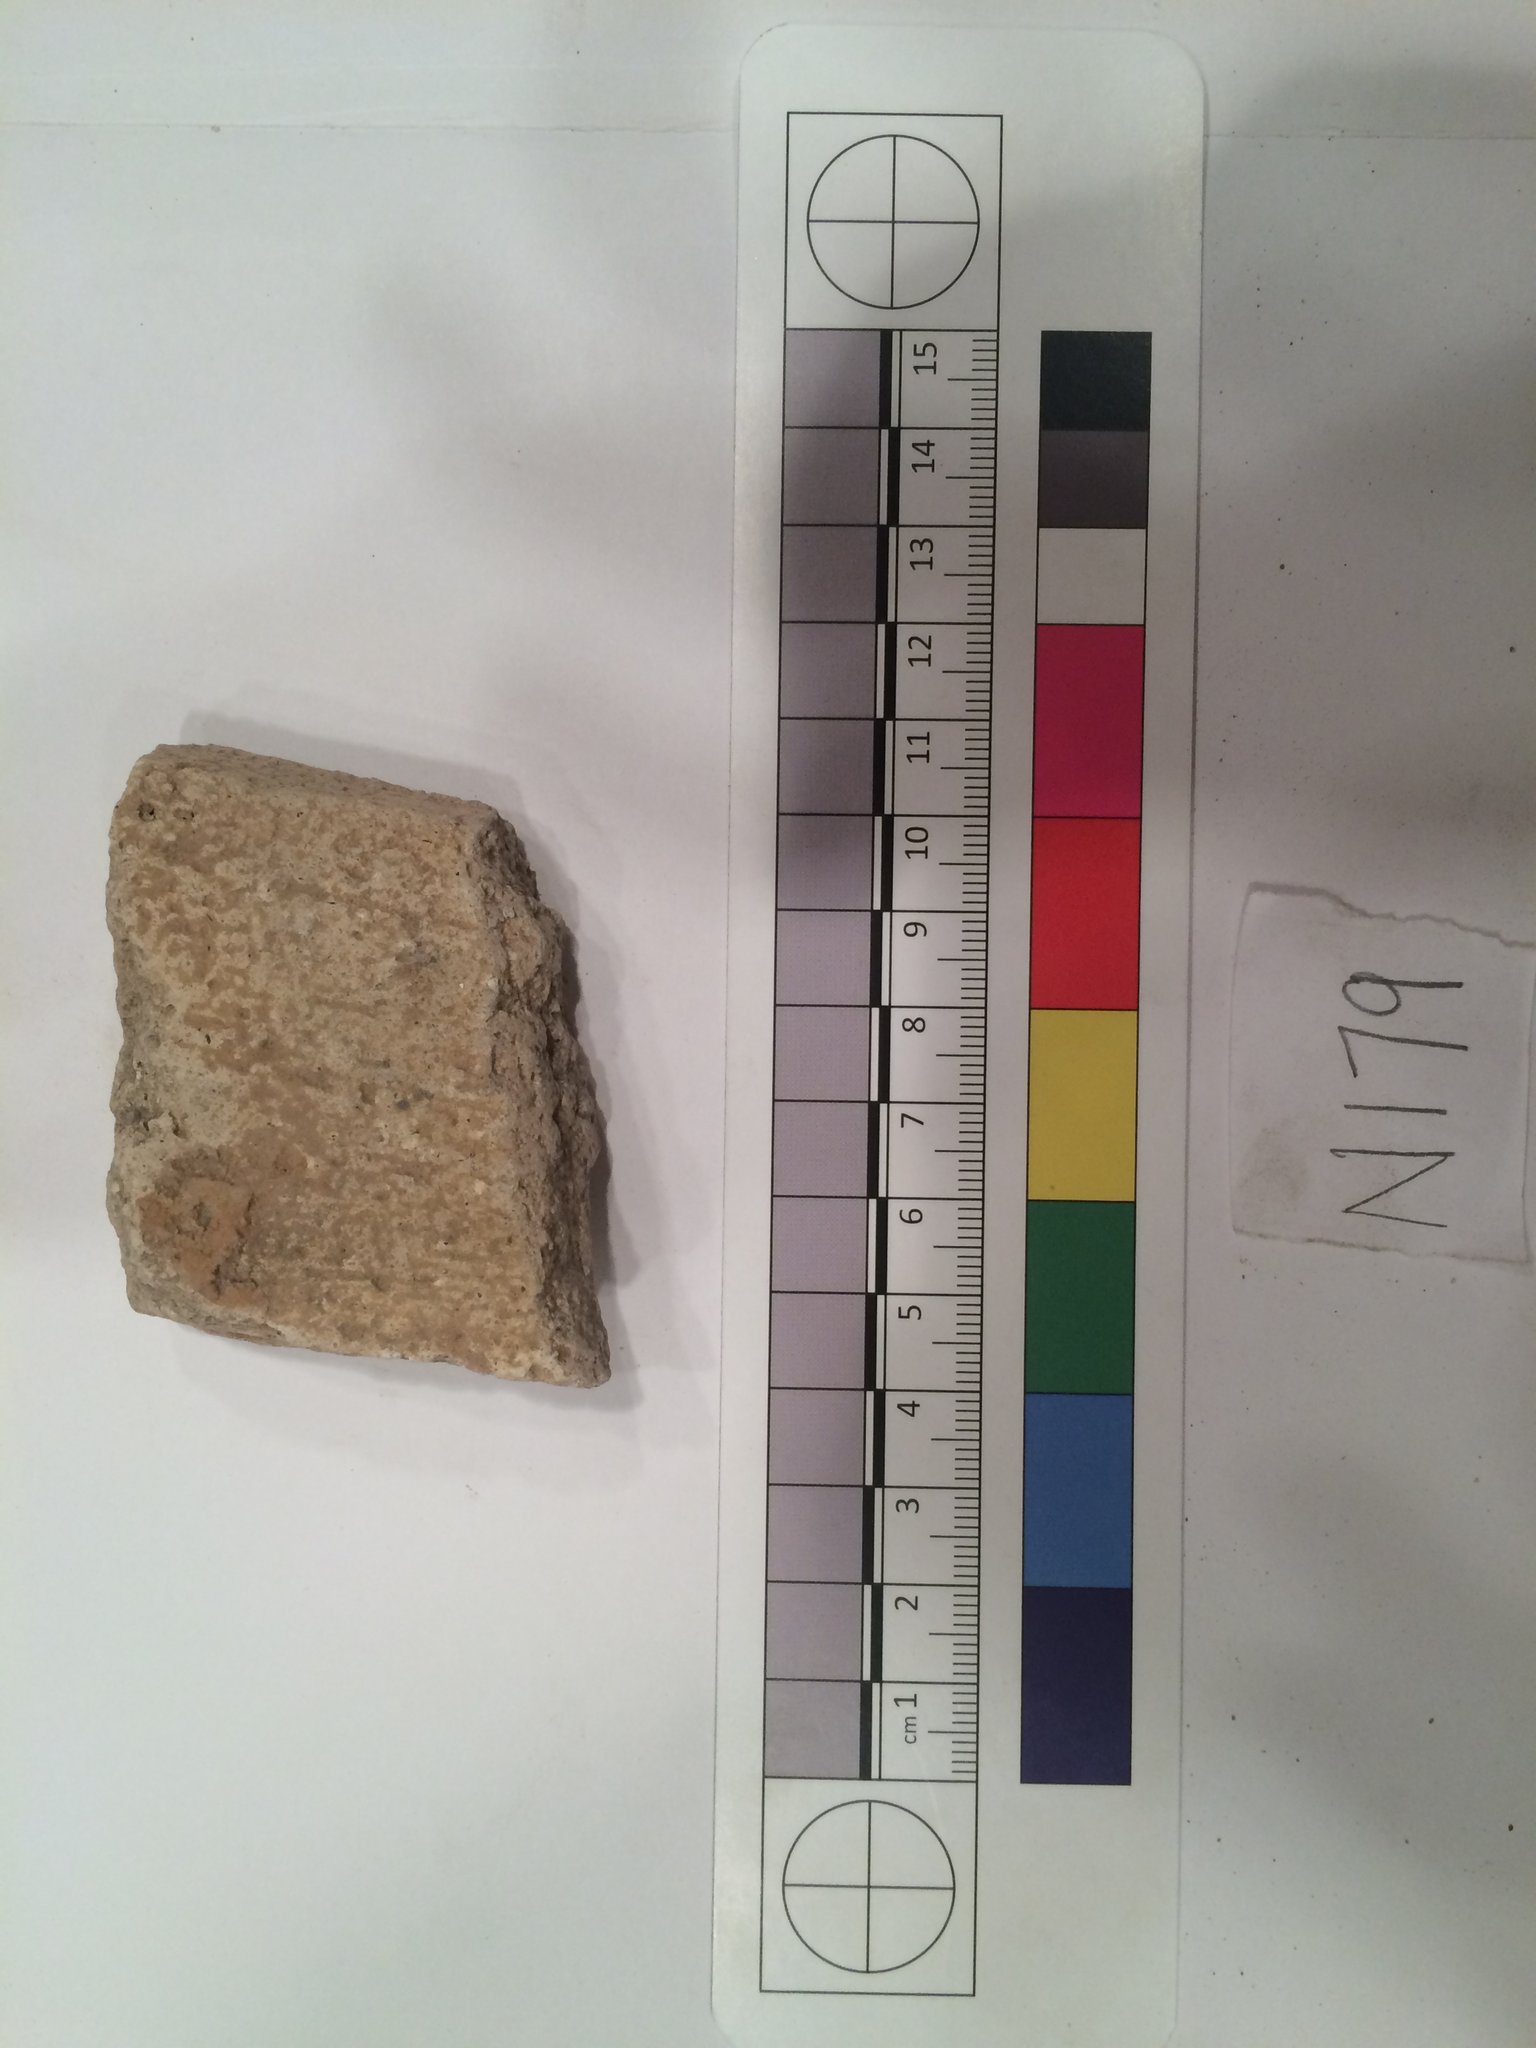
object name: fragment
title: Stucco Fragment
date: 701-1200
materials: plaster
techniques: carving, painting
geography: iran